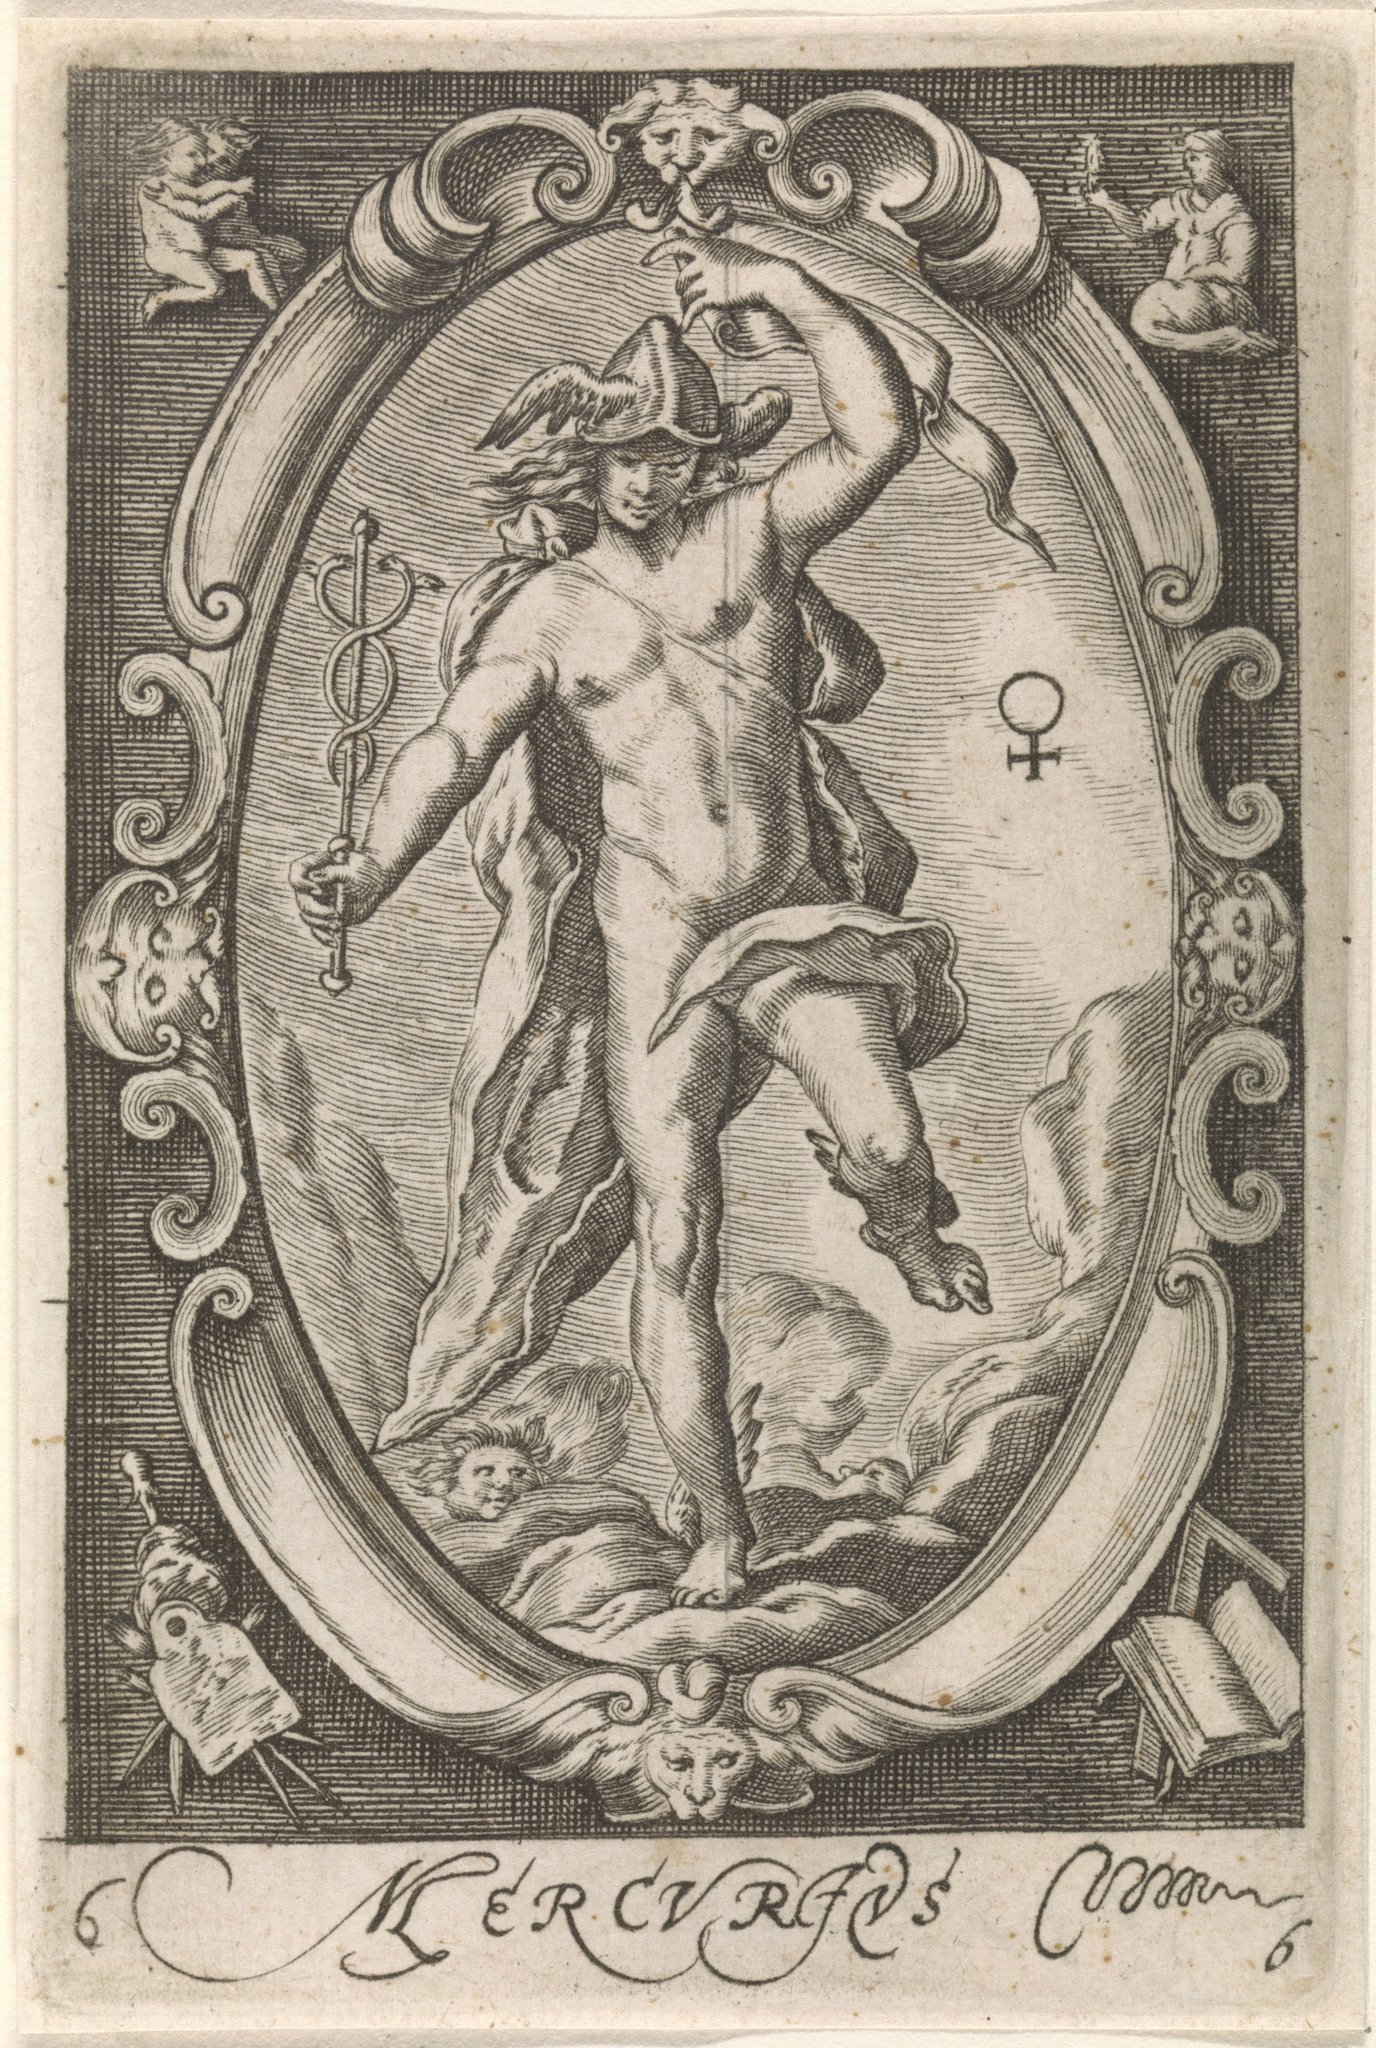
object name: print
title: De zeven planeten serie B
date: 1597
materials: paper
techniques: engraving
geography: amsterdam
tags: (story of) mercury (hermes), mercury (planet)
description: Mercurius, met in zijn hand een caduceus en op zijn hoofd een gevleugelde hoed (petasus). Rechts van hem het astronomische symbool voor zijn planeet. Staand in een ovaal cartouche met bovenaan de twee tekenen van de dierenriem: Tweelingen en Maagd.